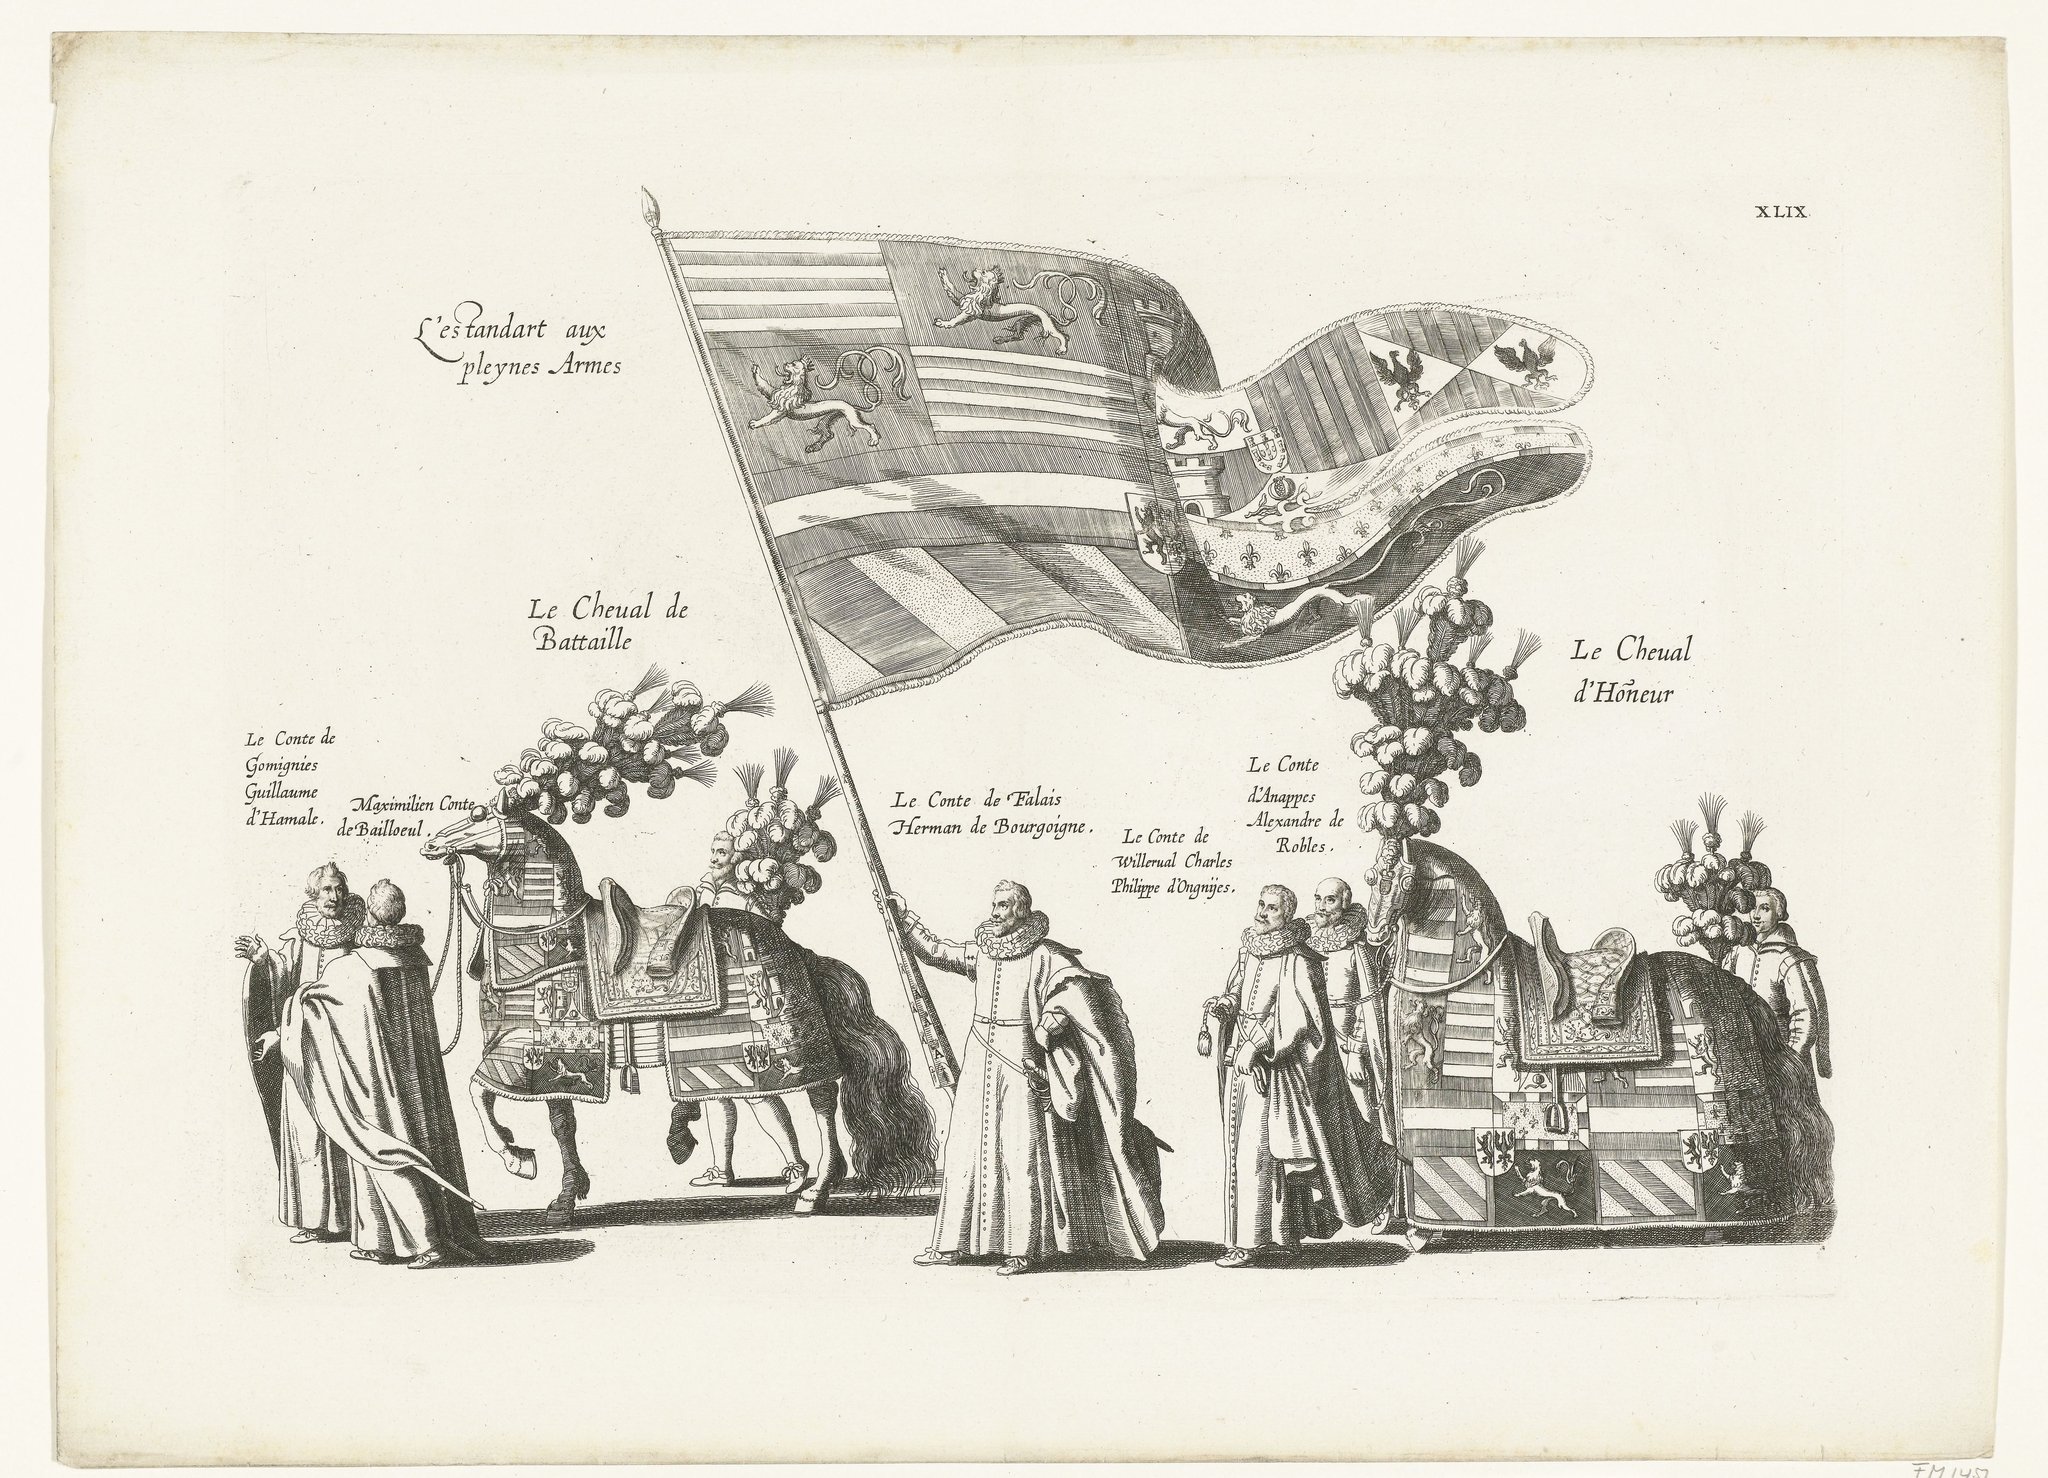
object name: print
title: Begrafenisstoet van aartshertog Albrecht (plaat XLIX), 1622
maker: cornelis galle (i)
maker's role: print maker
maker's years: 1576-1650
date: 1623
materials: paper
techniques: etching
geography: southern netherlands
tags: albrecht aartshertog van oostenrijk, cortege, funeral procession, brussels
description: Deelnemers in de begrafenisstoet met een groot vaandel en twee paarden. Plaat XLIX in de serie van de begrafenis van aartshertog Albrecht van Oostenrijk te Brussel op 12 maart 1622.